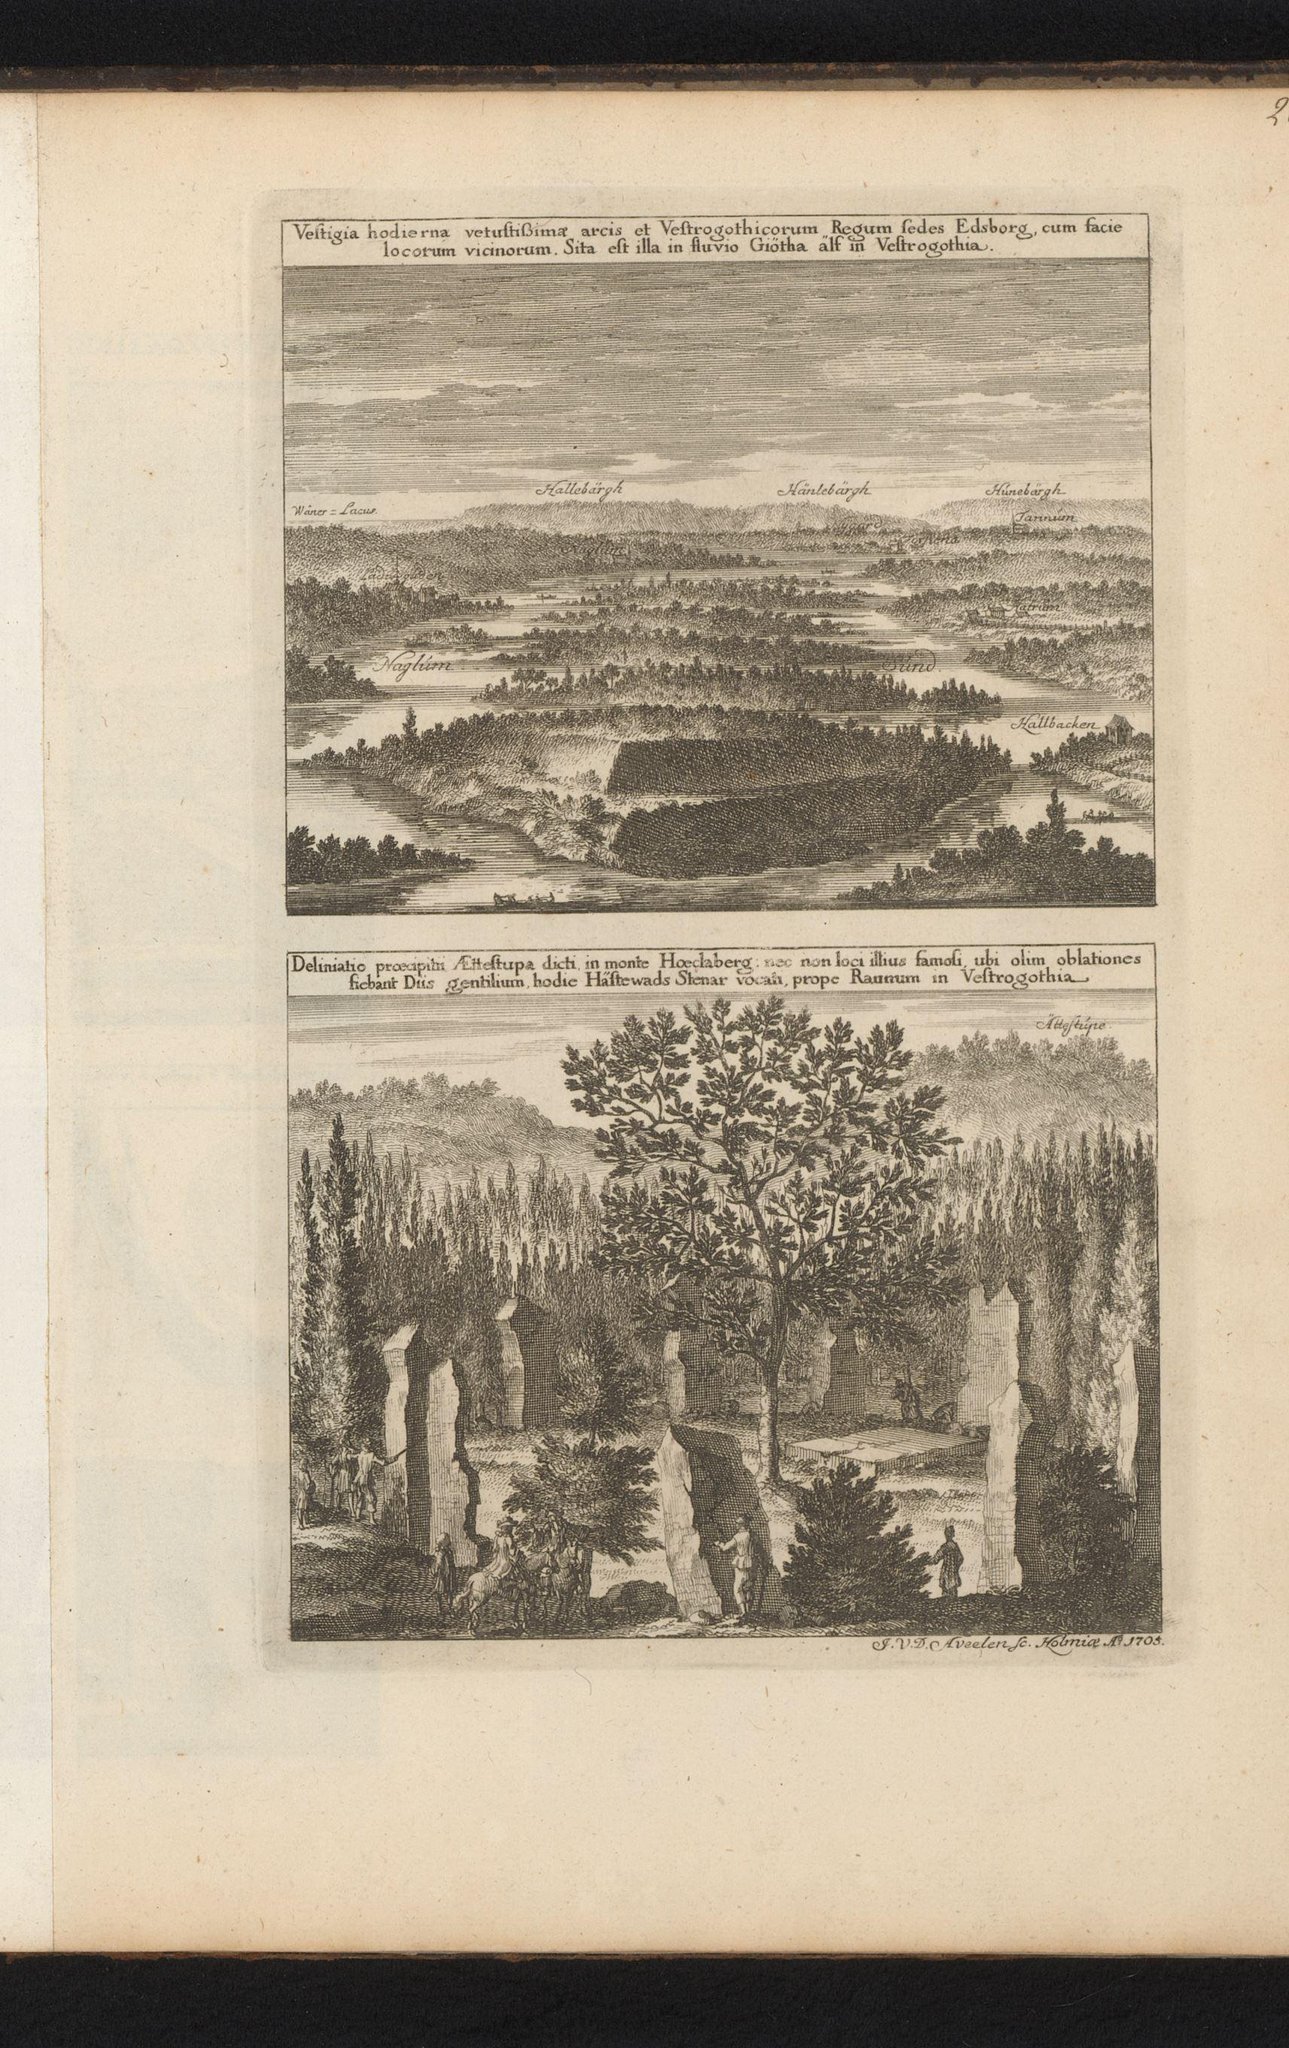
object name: print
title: Gezicht op de ruïnes van Edsborg, de afgrond Häckleberg en de stenen van Hästevad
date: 1705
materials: paper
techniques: etching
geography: stockholm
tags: västergötland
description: Kungliga Biblioteket, 'Suecia': http://www.kb.se/samlingarna/Kartor-bilder/Suecia-antiqua/ (geraadpleegd november 2016).